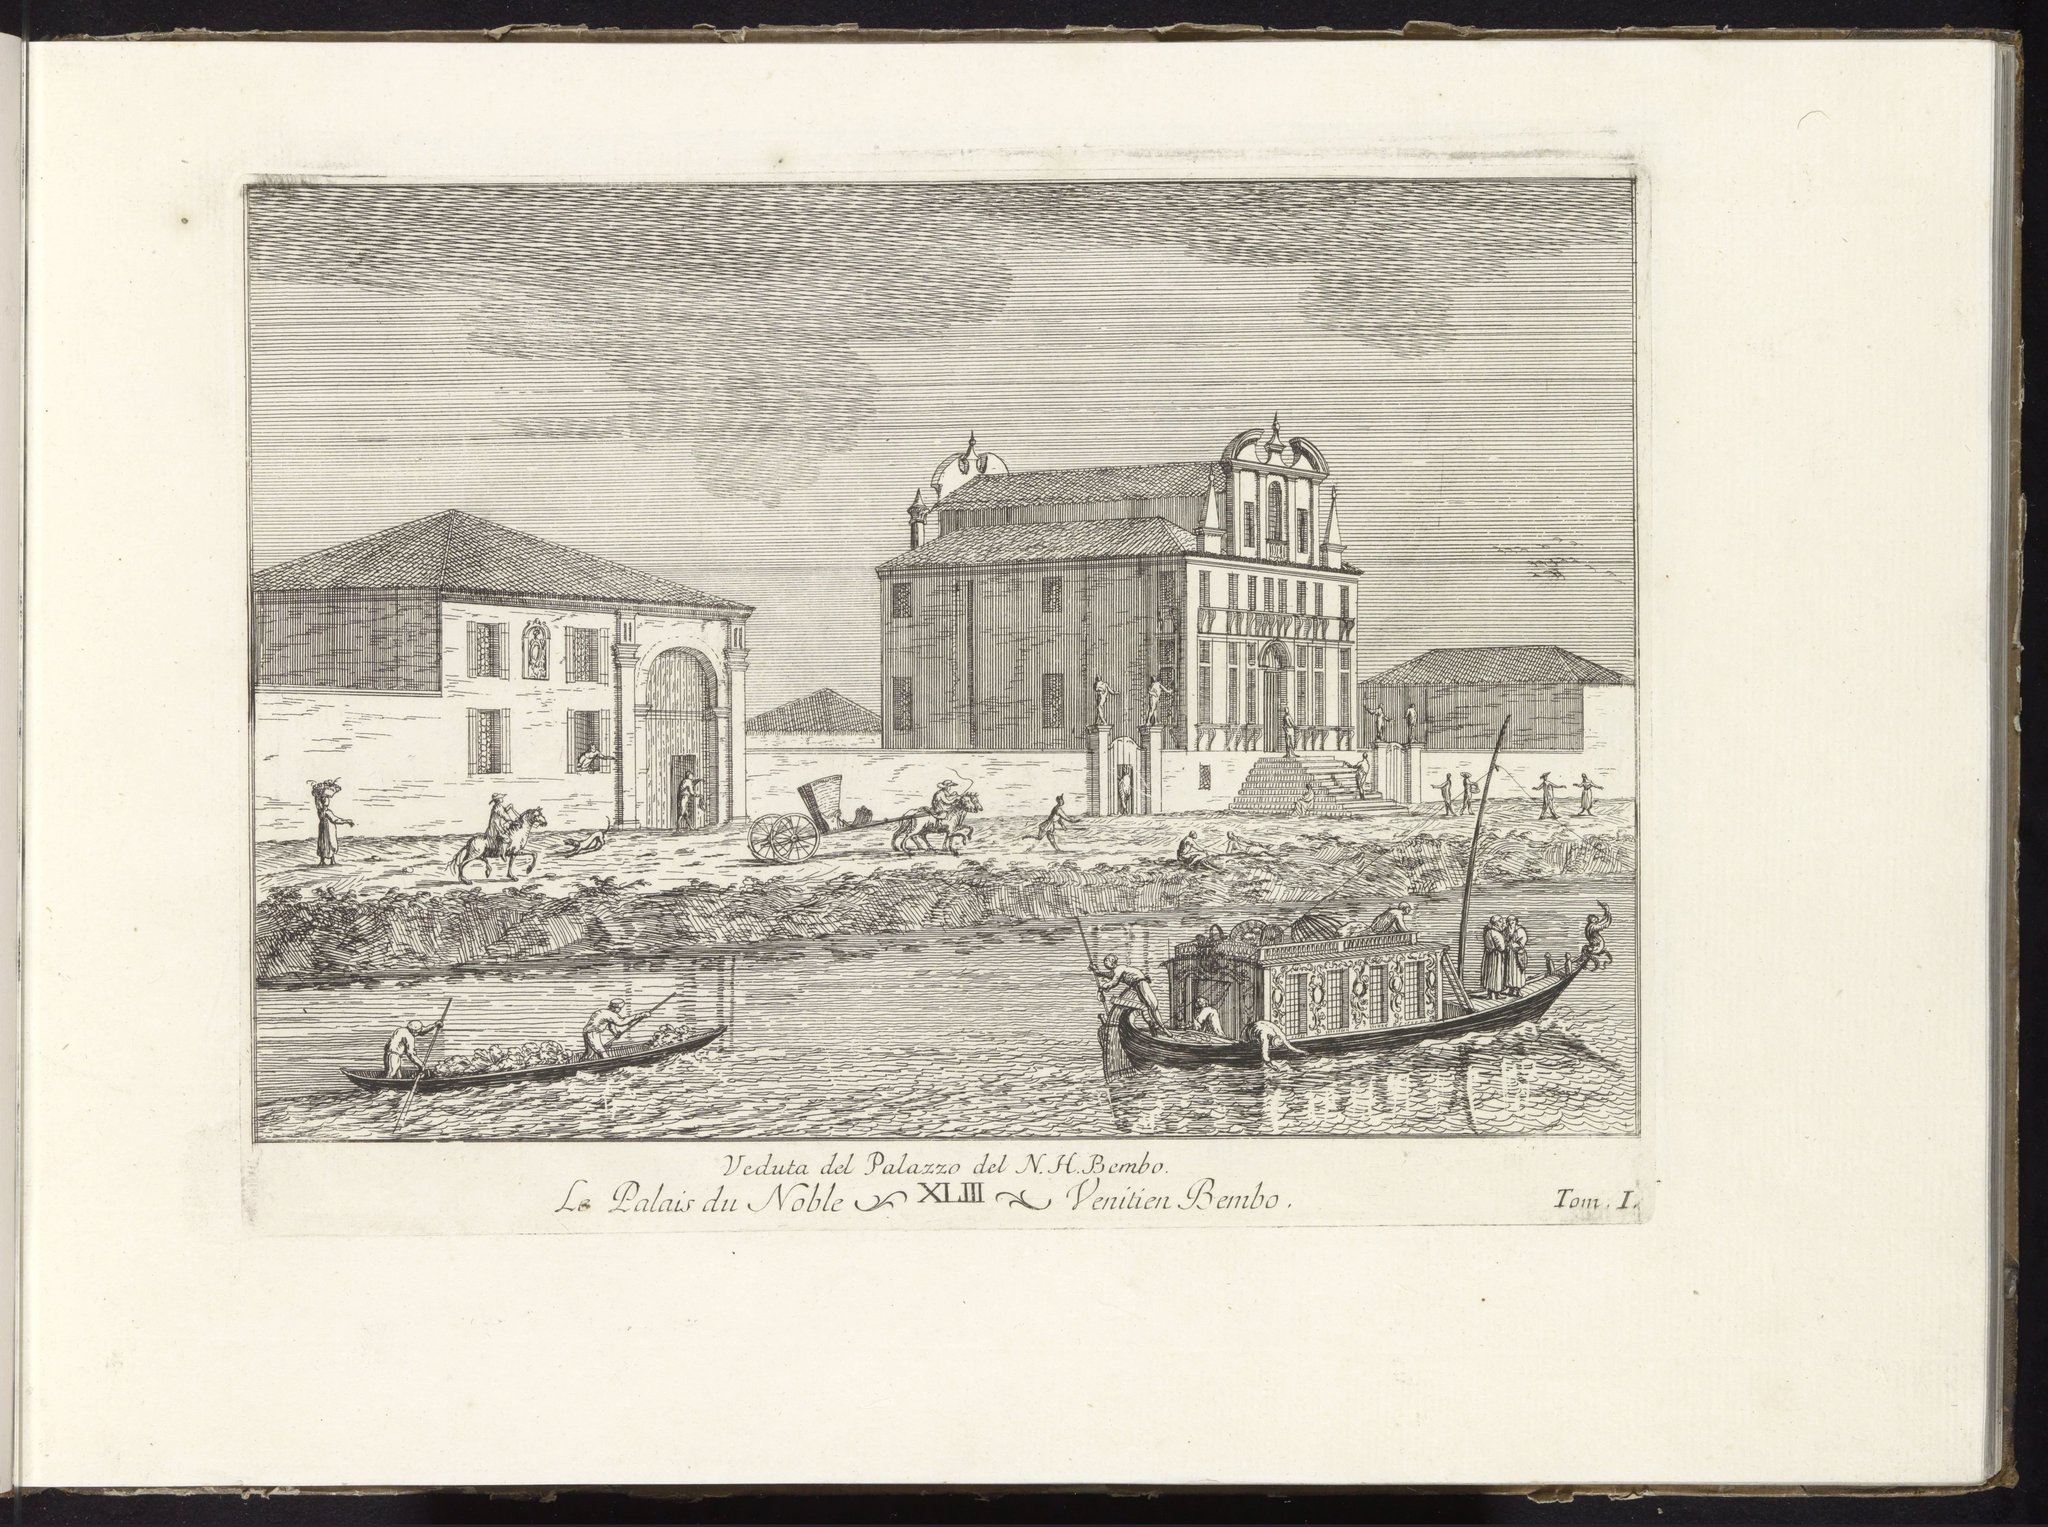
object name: print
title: Le delicie della Brenta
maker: giovanni francesco costa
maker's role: draughtsman, painter, print maker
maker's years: -1773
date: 1750-1760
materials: paper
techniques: etching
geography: italy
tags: river, hôtel, i.e. small palace in city, gondola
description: Gezicht op Palazzo del N. H. Bembo aan de rivier de Brenta. Op het water varen twee gondels. Genummerd midden onder: XLIII en rechtsonder: Tom: I. Deze prent maakt deel uit van een album.